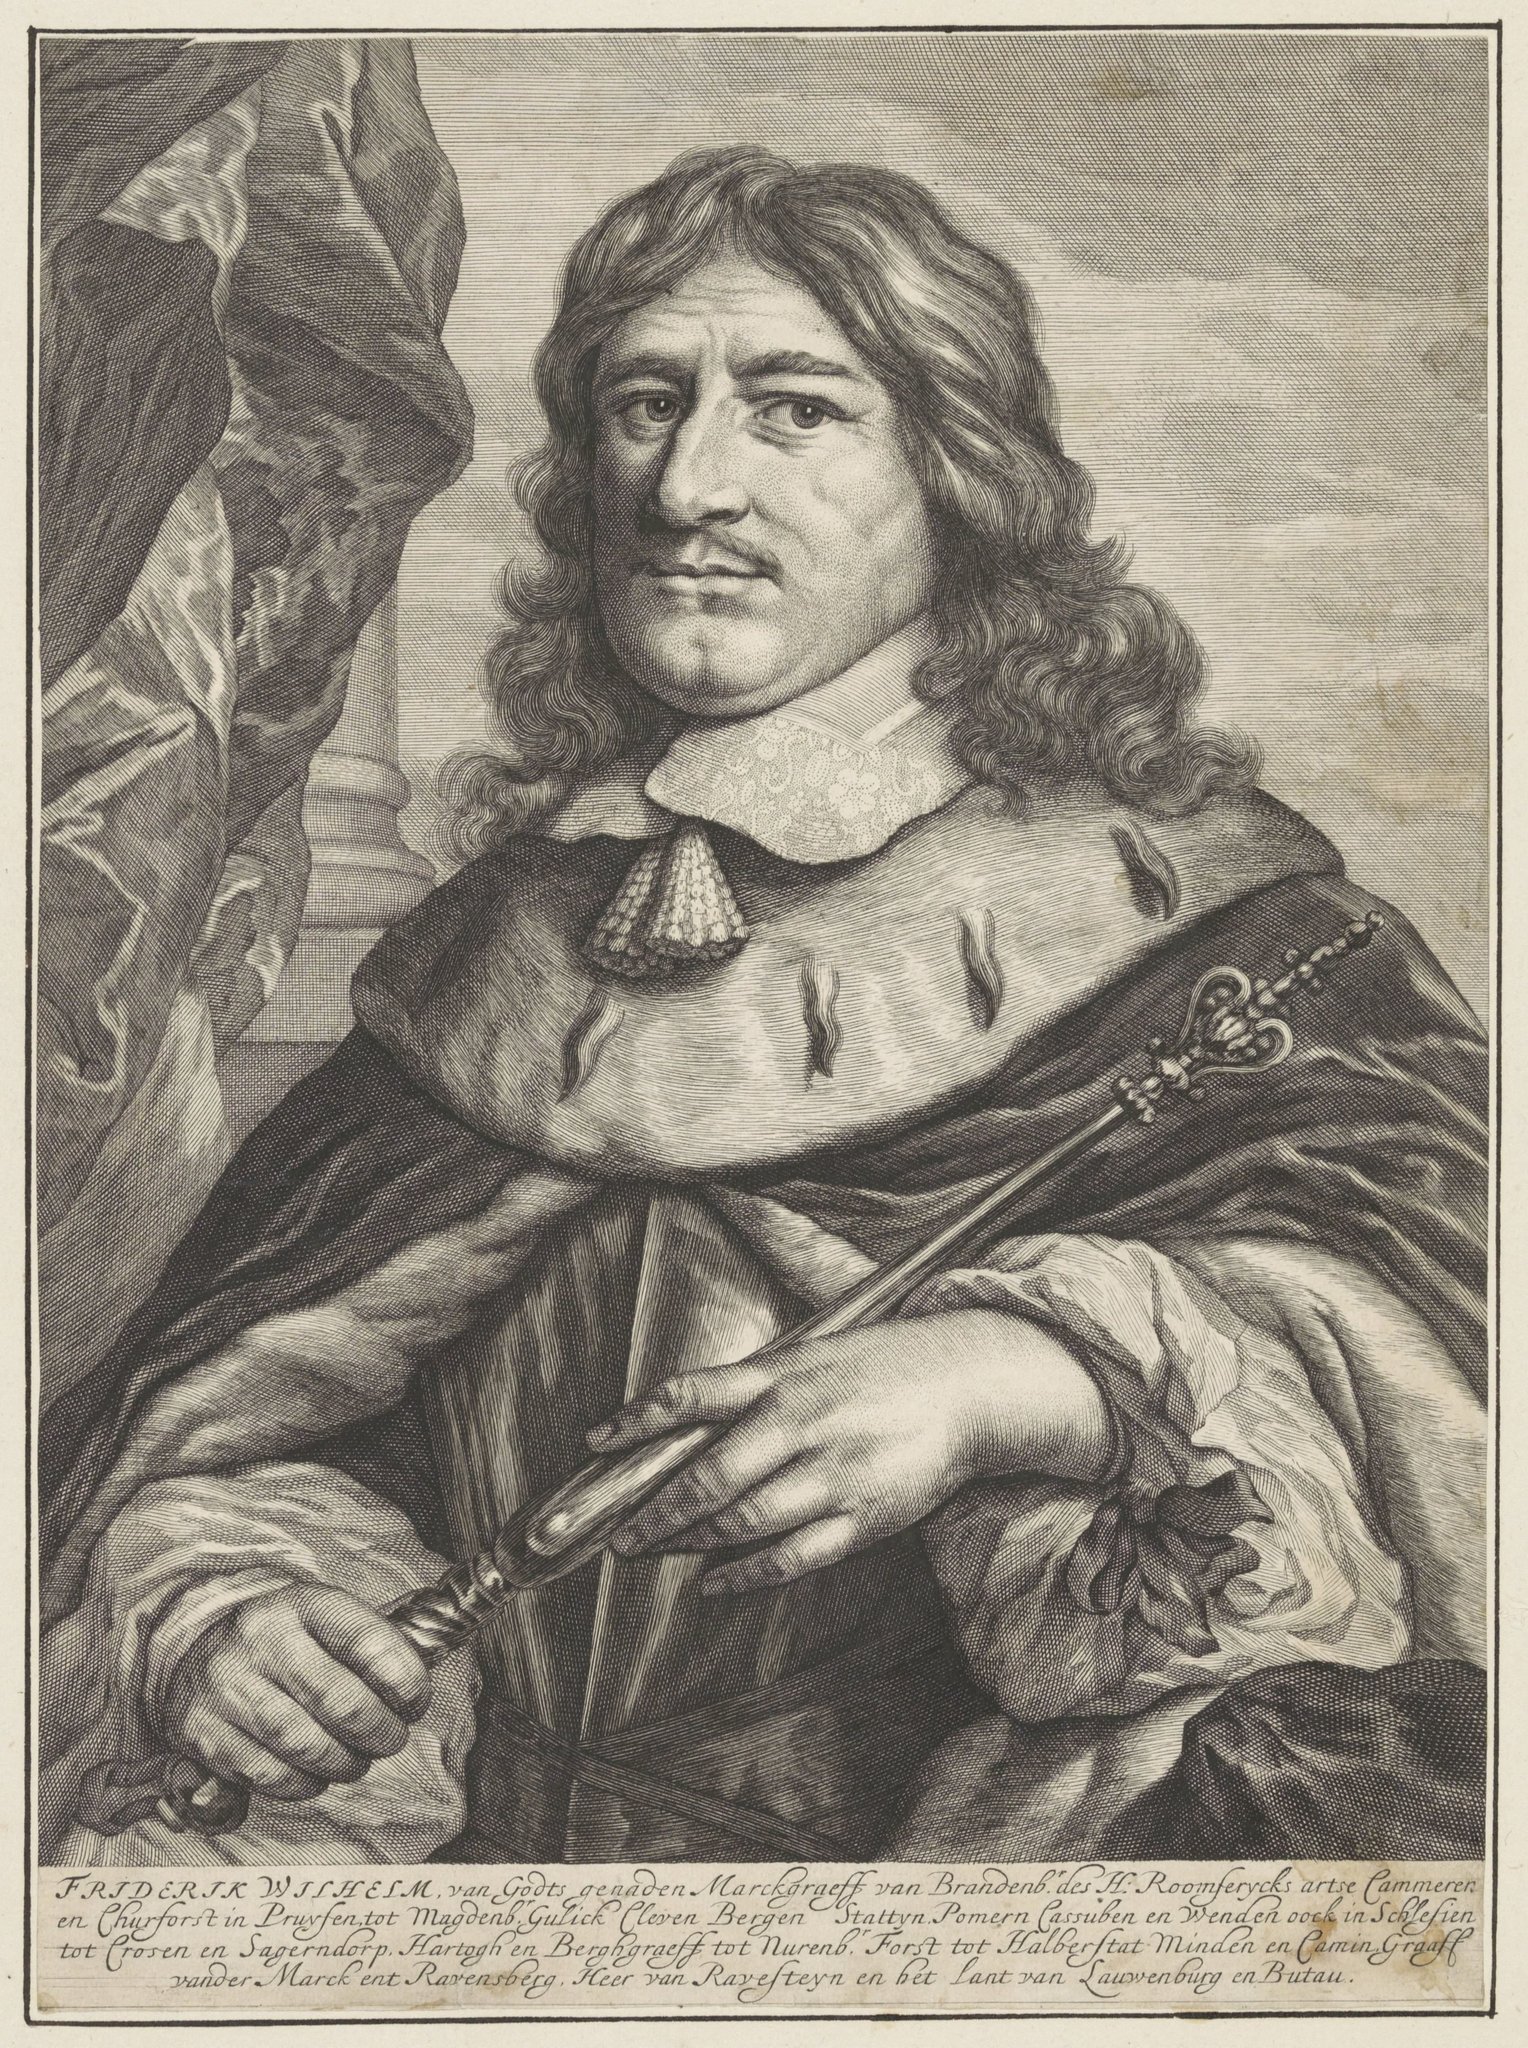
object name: print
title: Portret van Frederik Willem van Brandenburg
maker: theodor matham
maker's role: draughtsman, print maker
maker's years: 1605-1676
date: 1640-1676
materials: paper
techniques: engraving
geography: northern netherlands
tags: berlin, frederik willem van brandenburg (i)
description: Portret van Frederik Willem. In zijn handen een scepter. In de ondermarge zijn naam en titels.